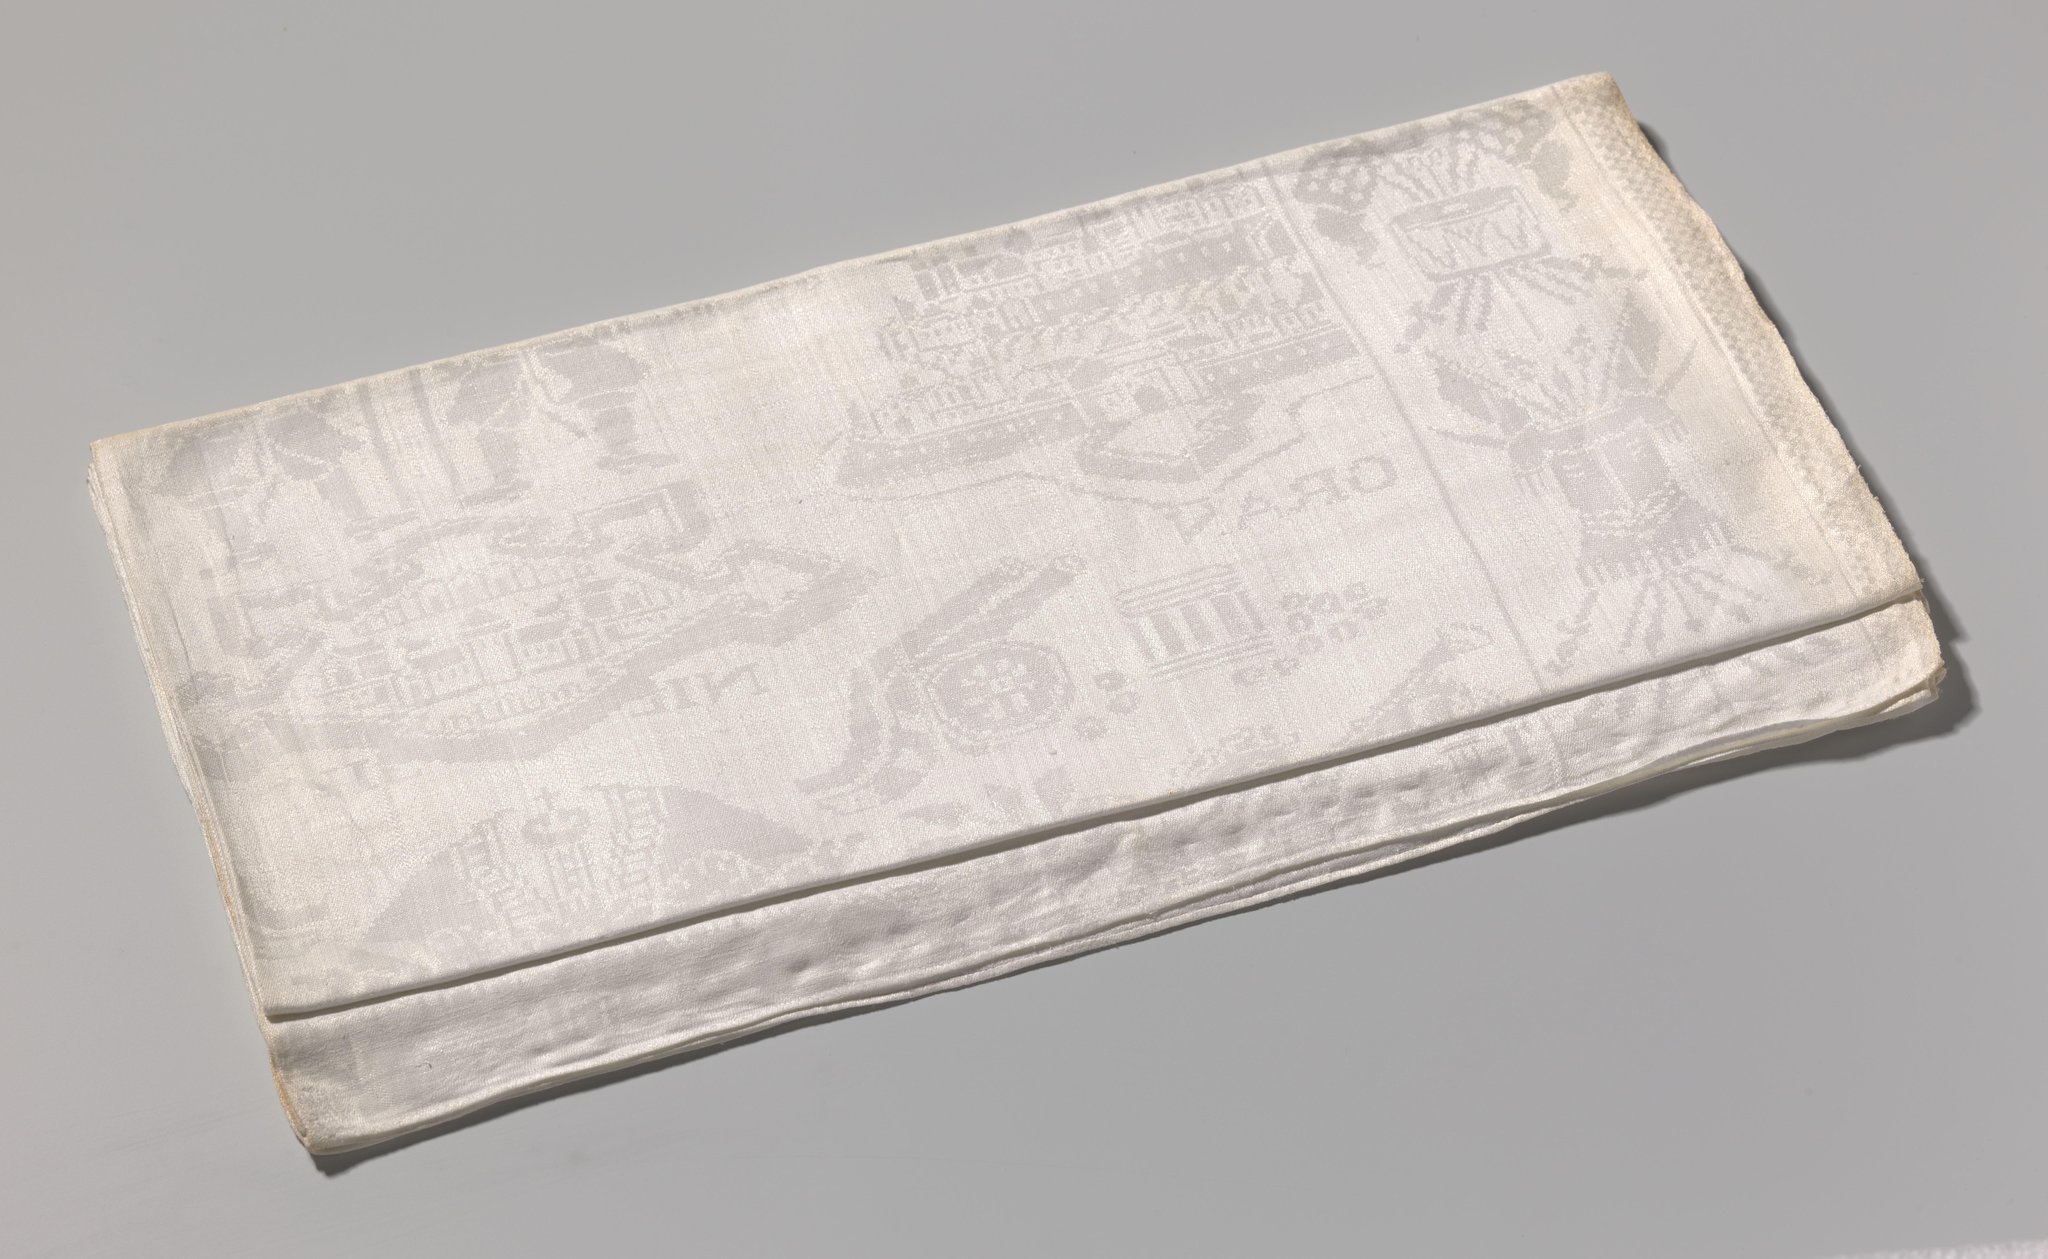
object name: tablecloth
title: Tafellaken met de verovering van Neuhäusel, Gran, Buda en Pest door Leopold I, keizer van Duitsland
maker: Anonymous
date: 1686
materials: linen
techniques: damask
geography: flanders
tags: vienna, leopold i (keizer van duitsland)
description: Tafellaken van linnendamast met de verovering van Neuhäusel, Gran, Buda en Pest door Leopold I, keizer van Duitsland.